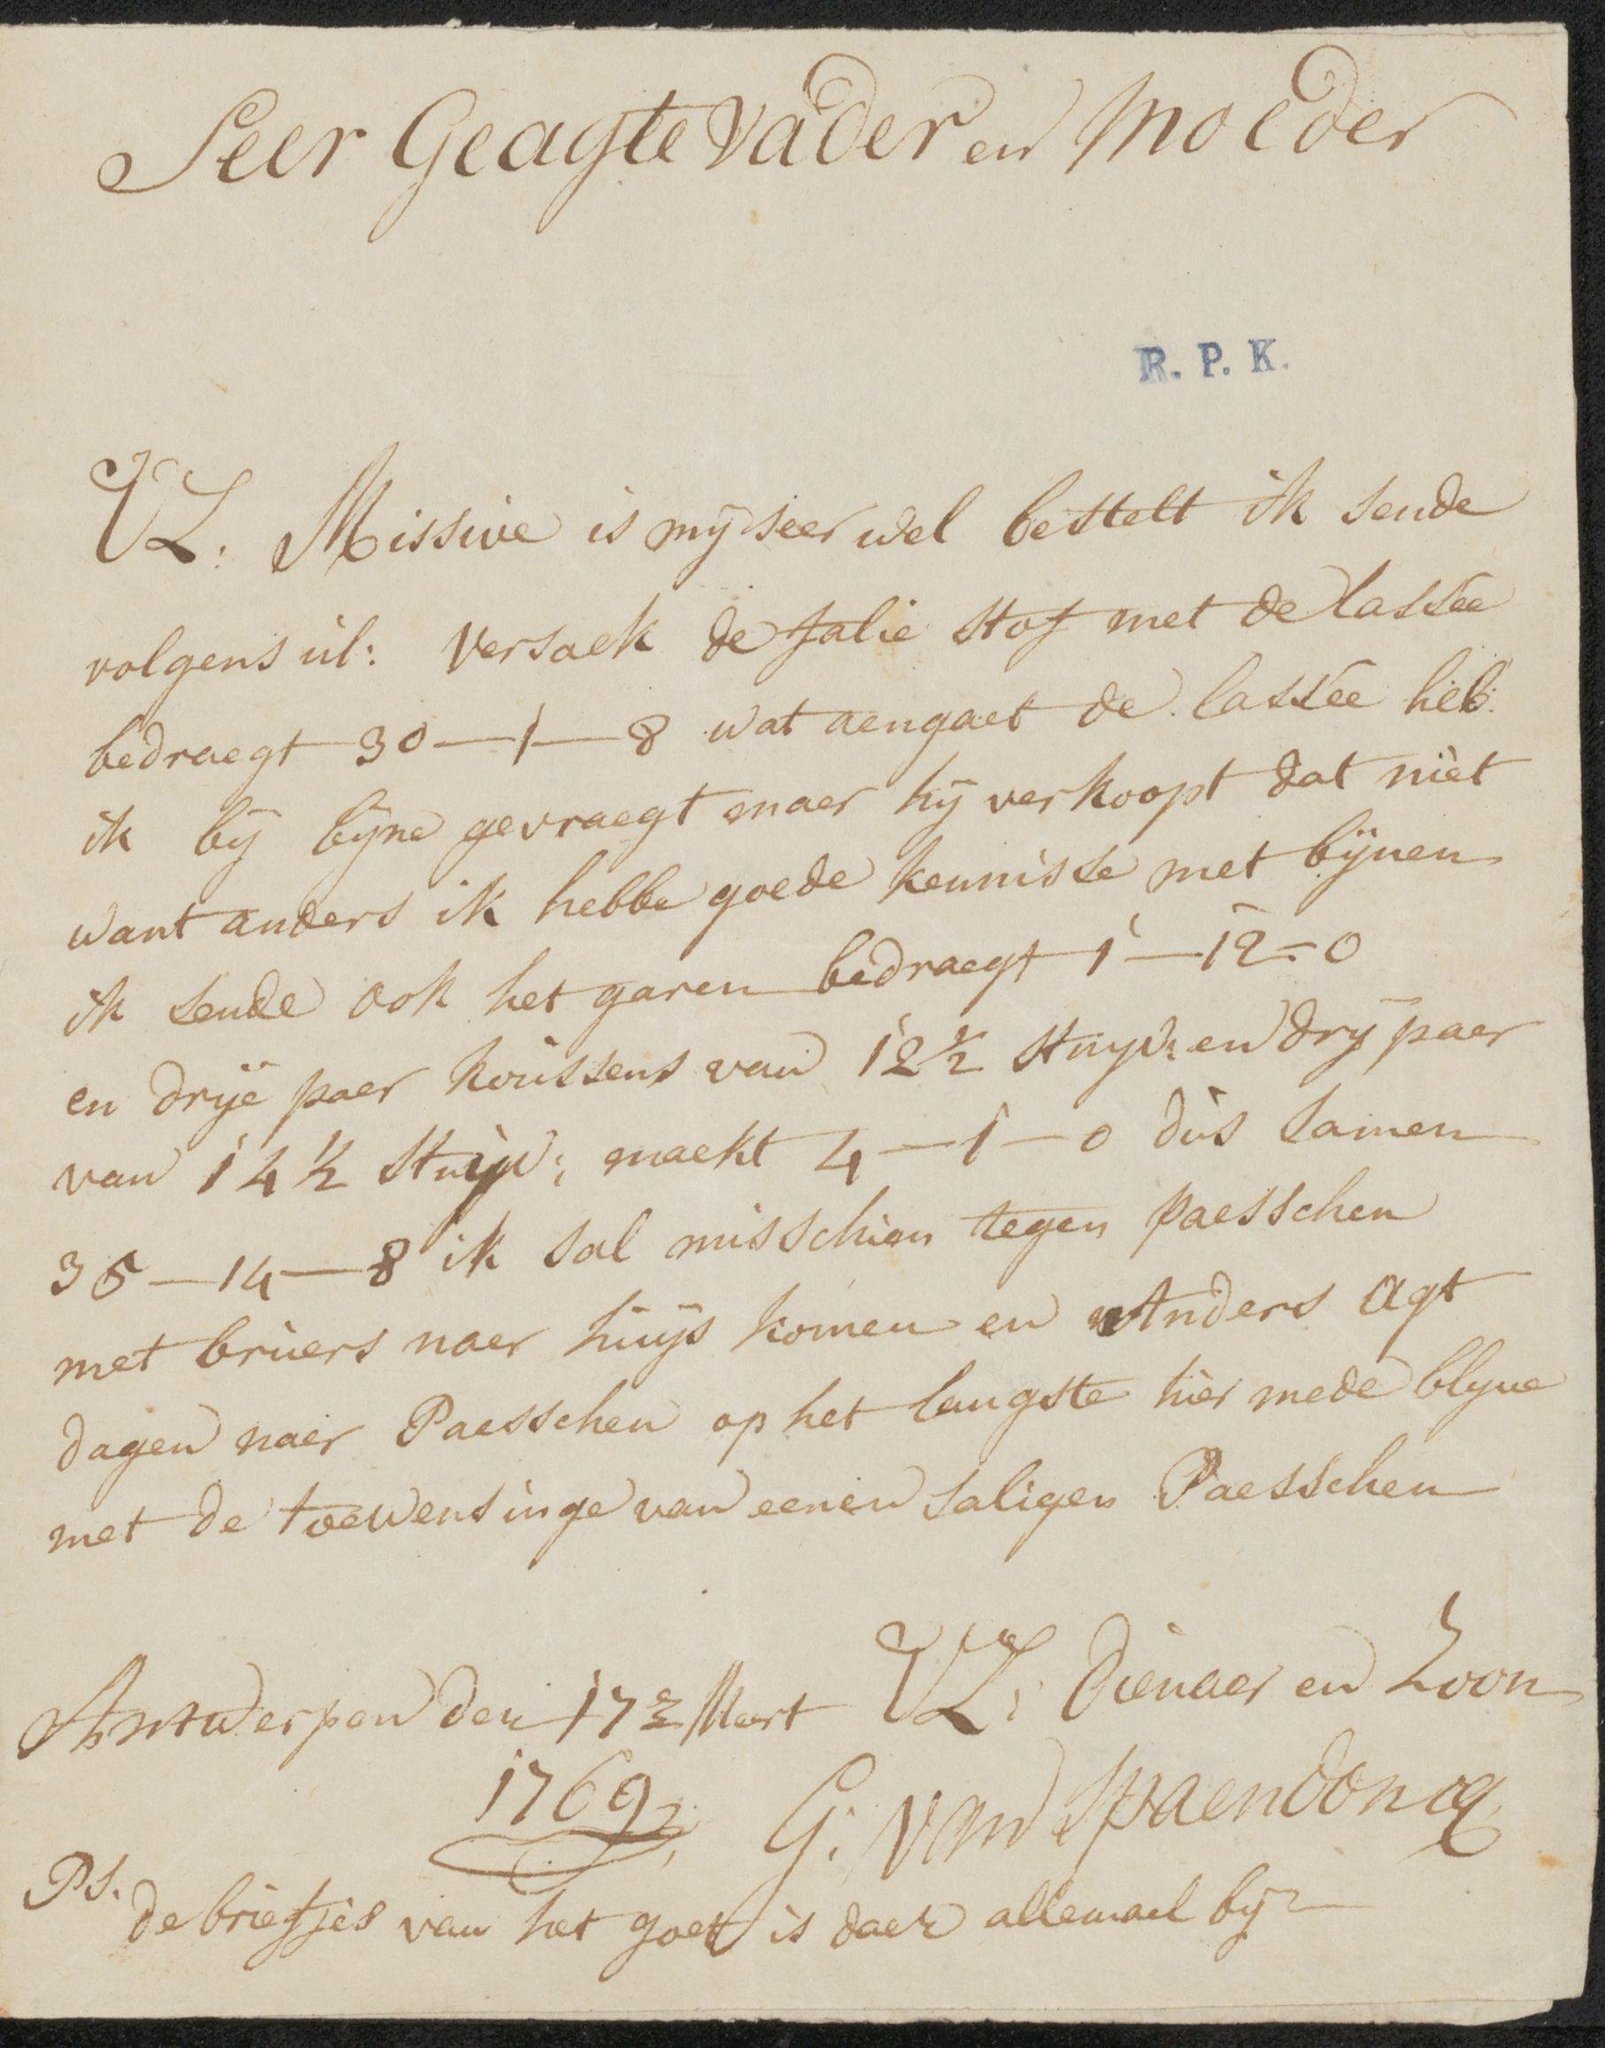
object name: letter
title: Brief aan de vader en moeder van Gerard van Spaendonck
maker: gerard van spaendonck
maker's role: draughtsman, print maker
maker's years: 1746-1822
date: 1769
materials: ink, paper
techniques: pen, writing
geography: antwerp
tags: money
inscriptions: collector's mark: ‘RPK’, watermark